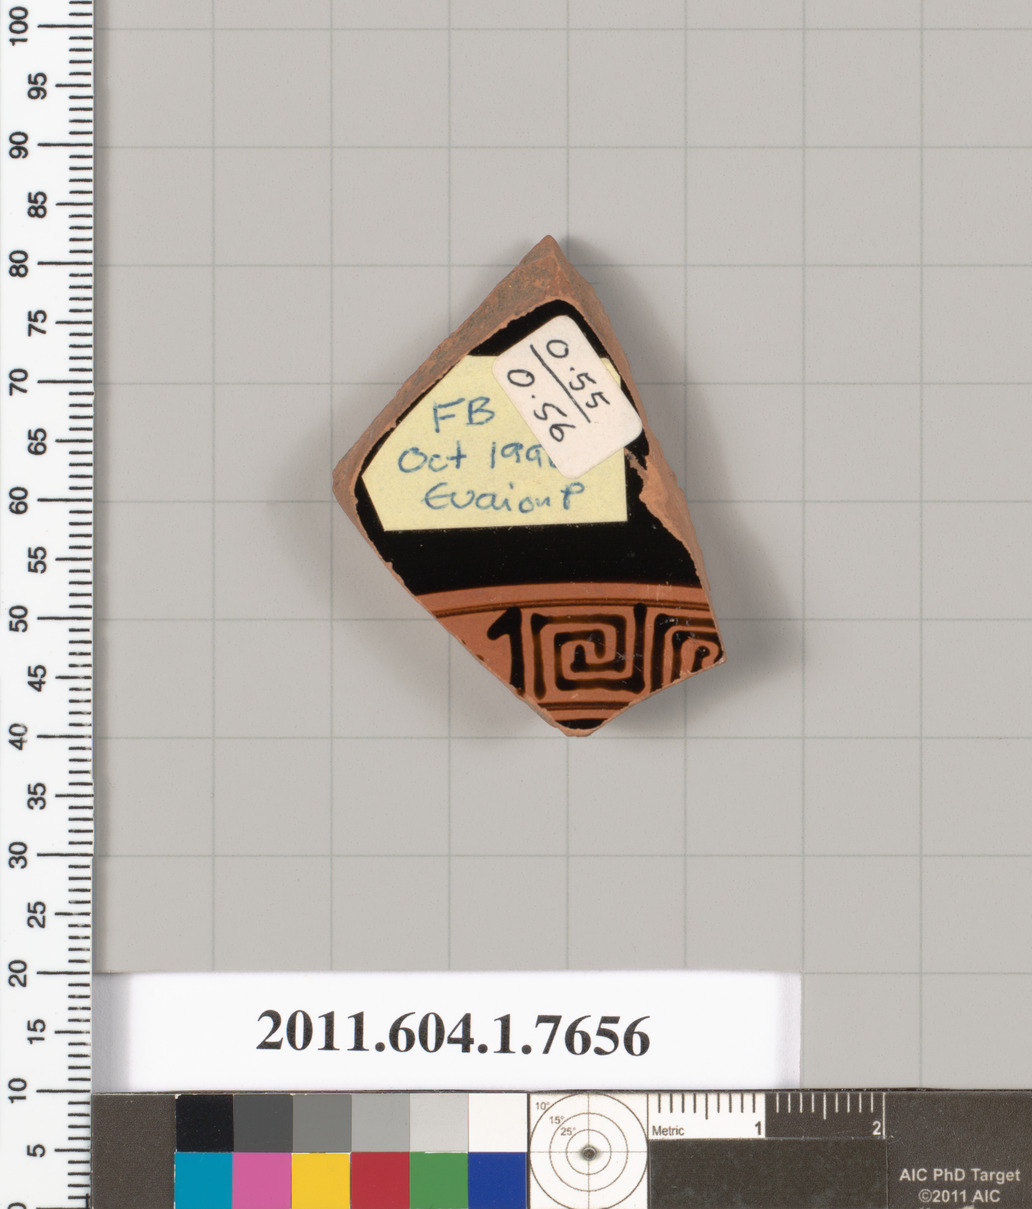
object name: kylix fragment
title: Terracotta fragment of a kylix (drinking cup)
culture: greek, attic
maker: euaion painter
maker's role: artist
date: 460-450 BCE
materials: terracotta